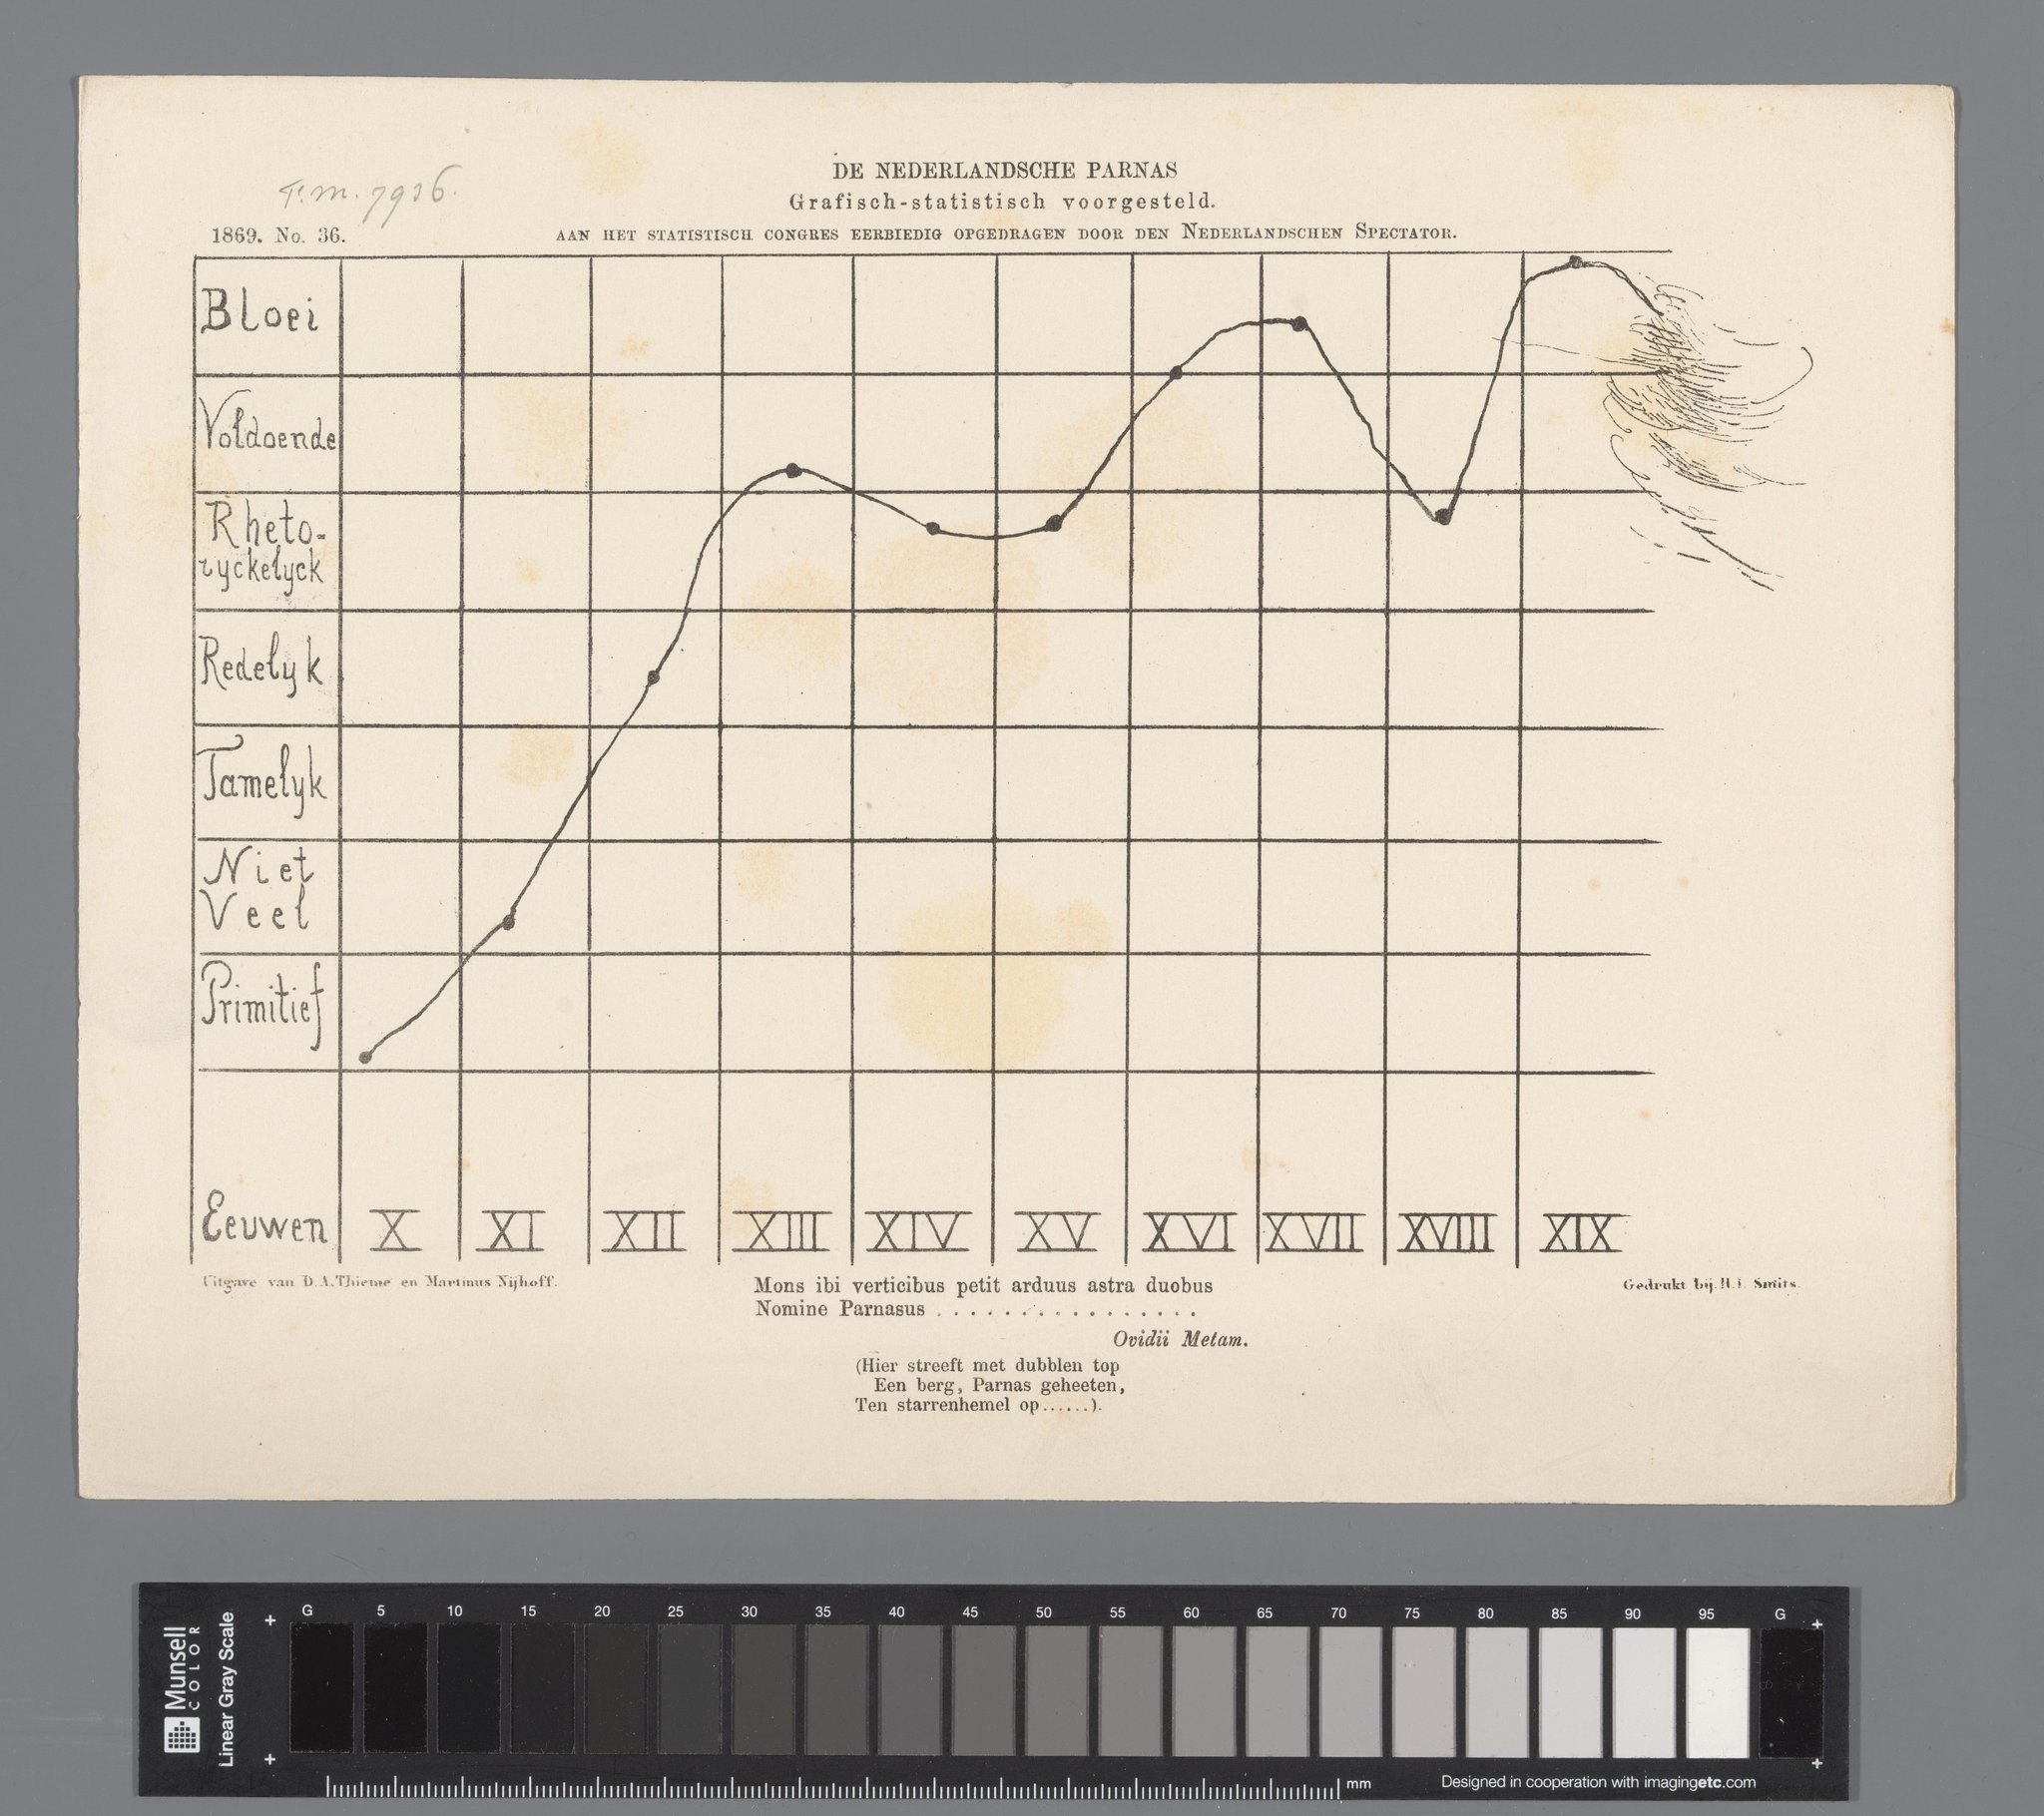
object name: print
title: De Nederlandsche Parnas Grafisch-statistisch voorgesteld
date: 1869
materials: paper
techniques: lithograph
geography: the hague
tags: statistic diagram, graph; pictorial chart, etc.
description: Spotprent nav het Statistisch Congres. Tabel van de Nederlandse dichtkunde van de 10e tot de 19e eeuw. Plaat verschenen bij het weekblad De Nederlandsche Spectator, nr. 36, 1869.